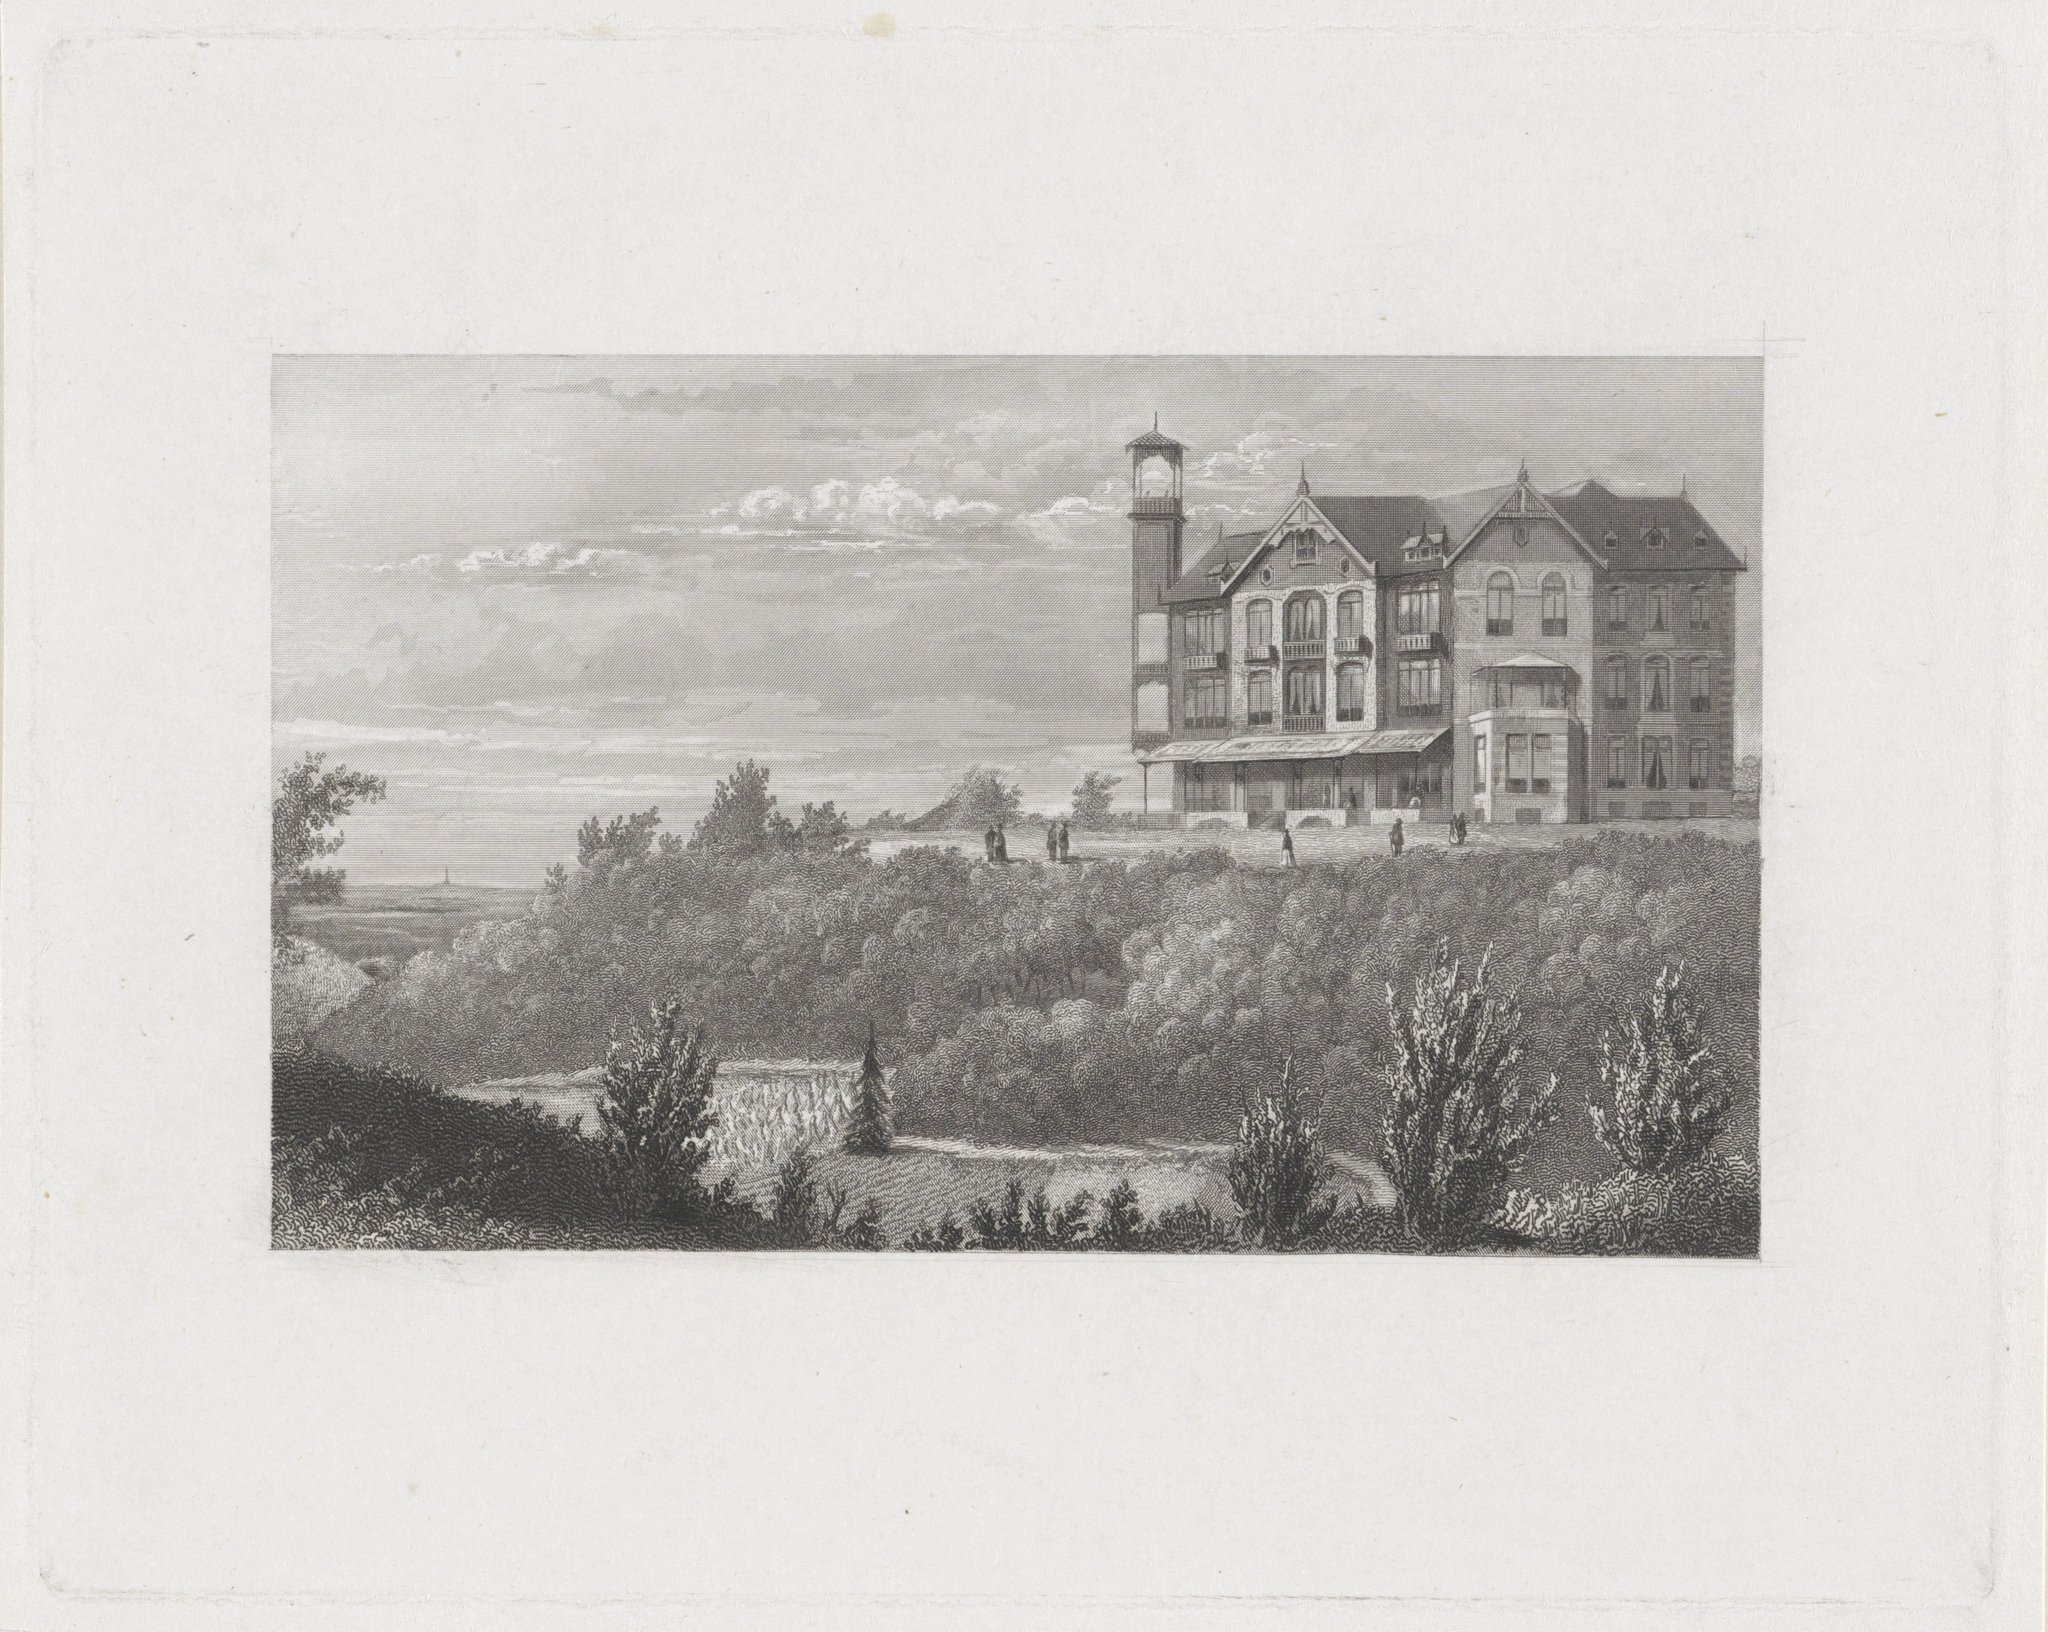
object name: print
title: Groot landhuis op een heuvel met wandelaars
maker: dirk jurriaan sluyter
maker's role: draughtsman, print maker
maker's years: 1811-1886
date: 1826-1886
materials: paper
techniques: etching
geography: amsterdam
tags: villa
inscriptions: collector's mark: Lugt 2228